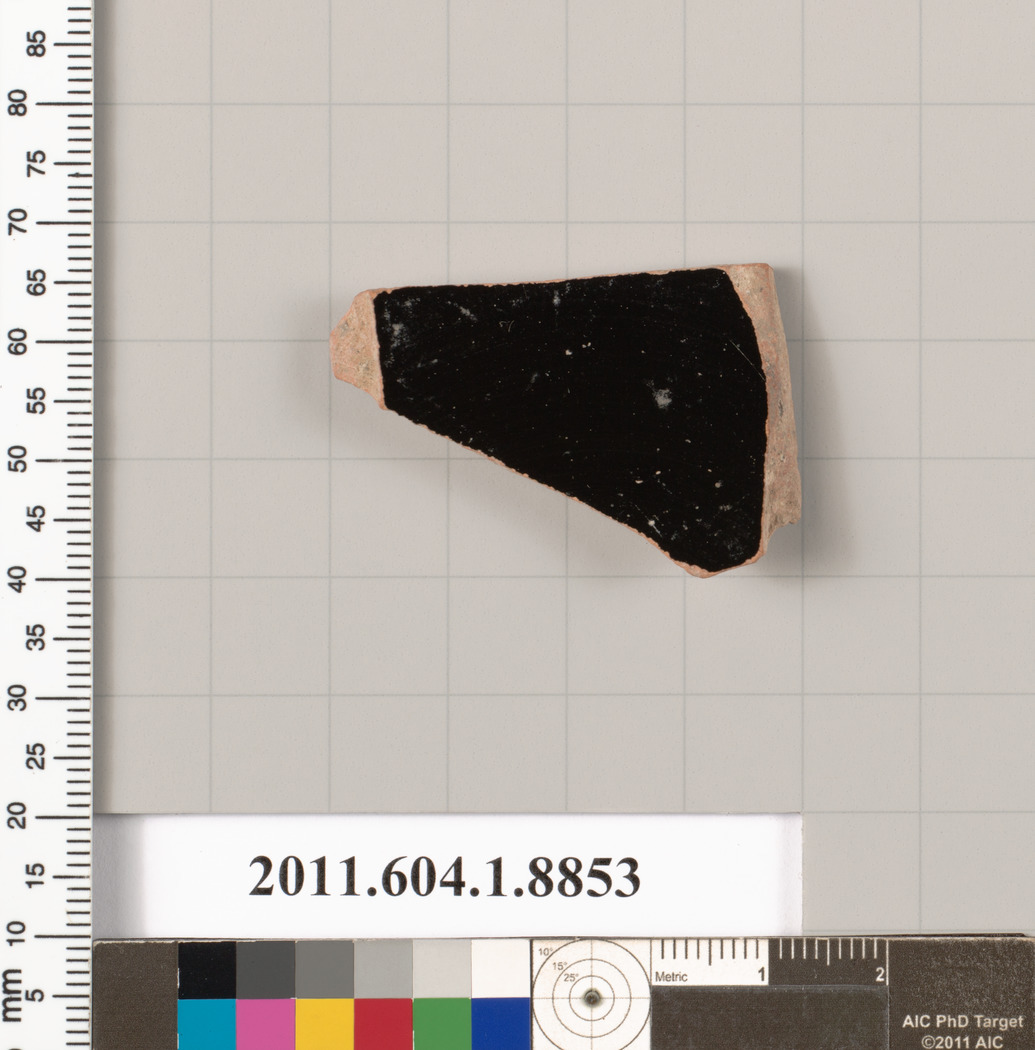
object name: kylix fragment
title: Terracotta fragment of a kylix (drinking cup)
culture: greek, attic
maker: makron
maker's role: artist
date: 490-470 BCE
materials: terracotta